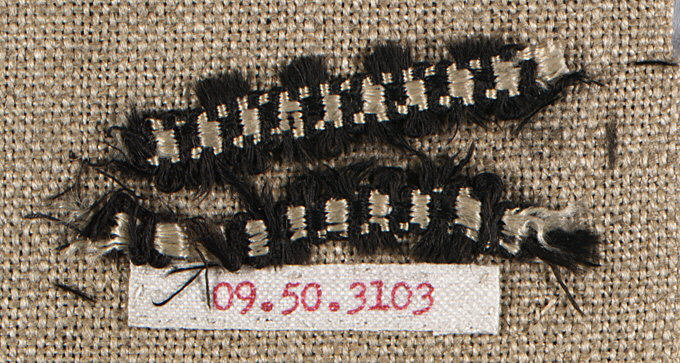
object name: gimp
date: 1801-1900